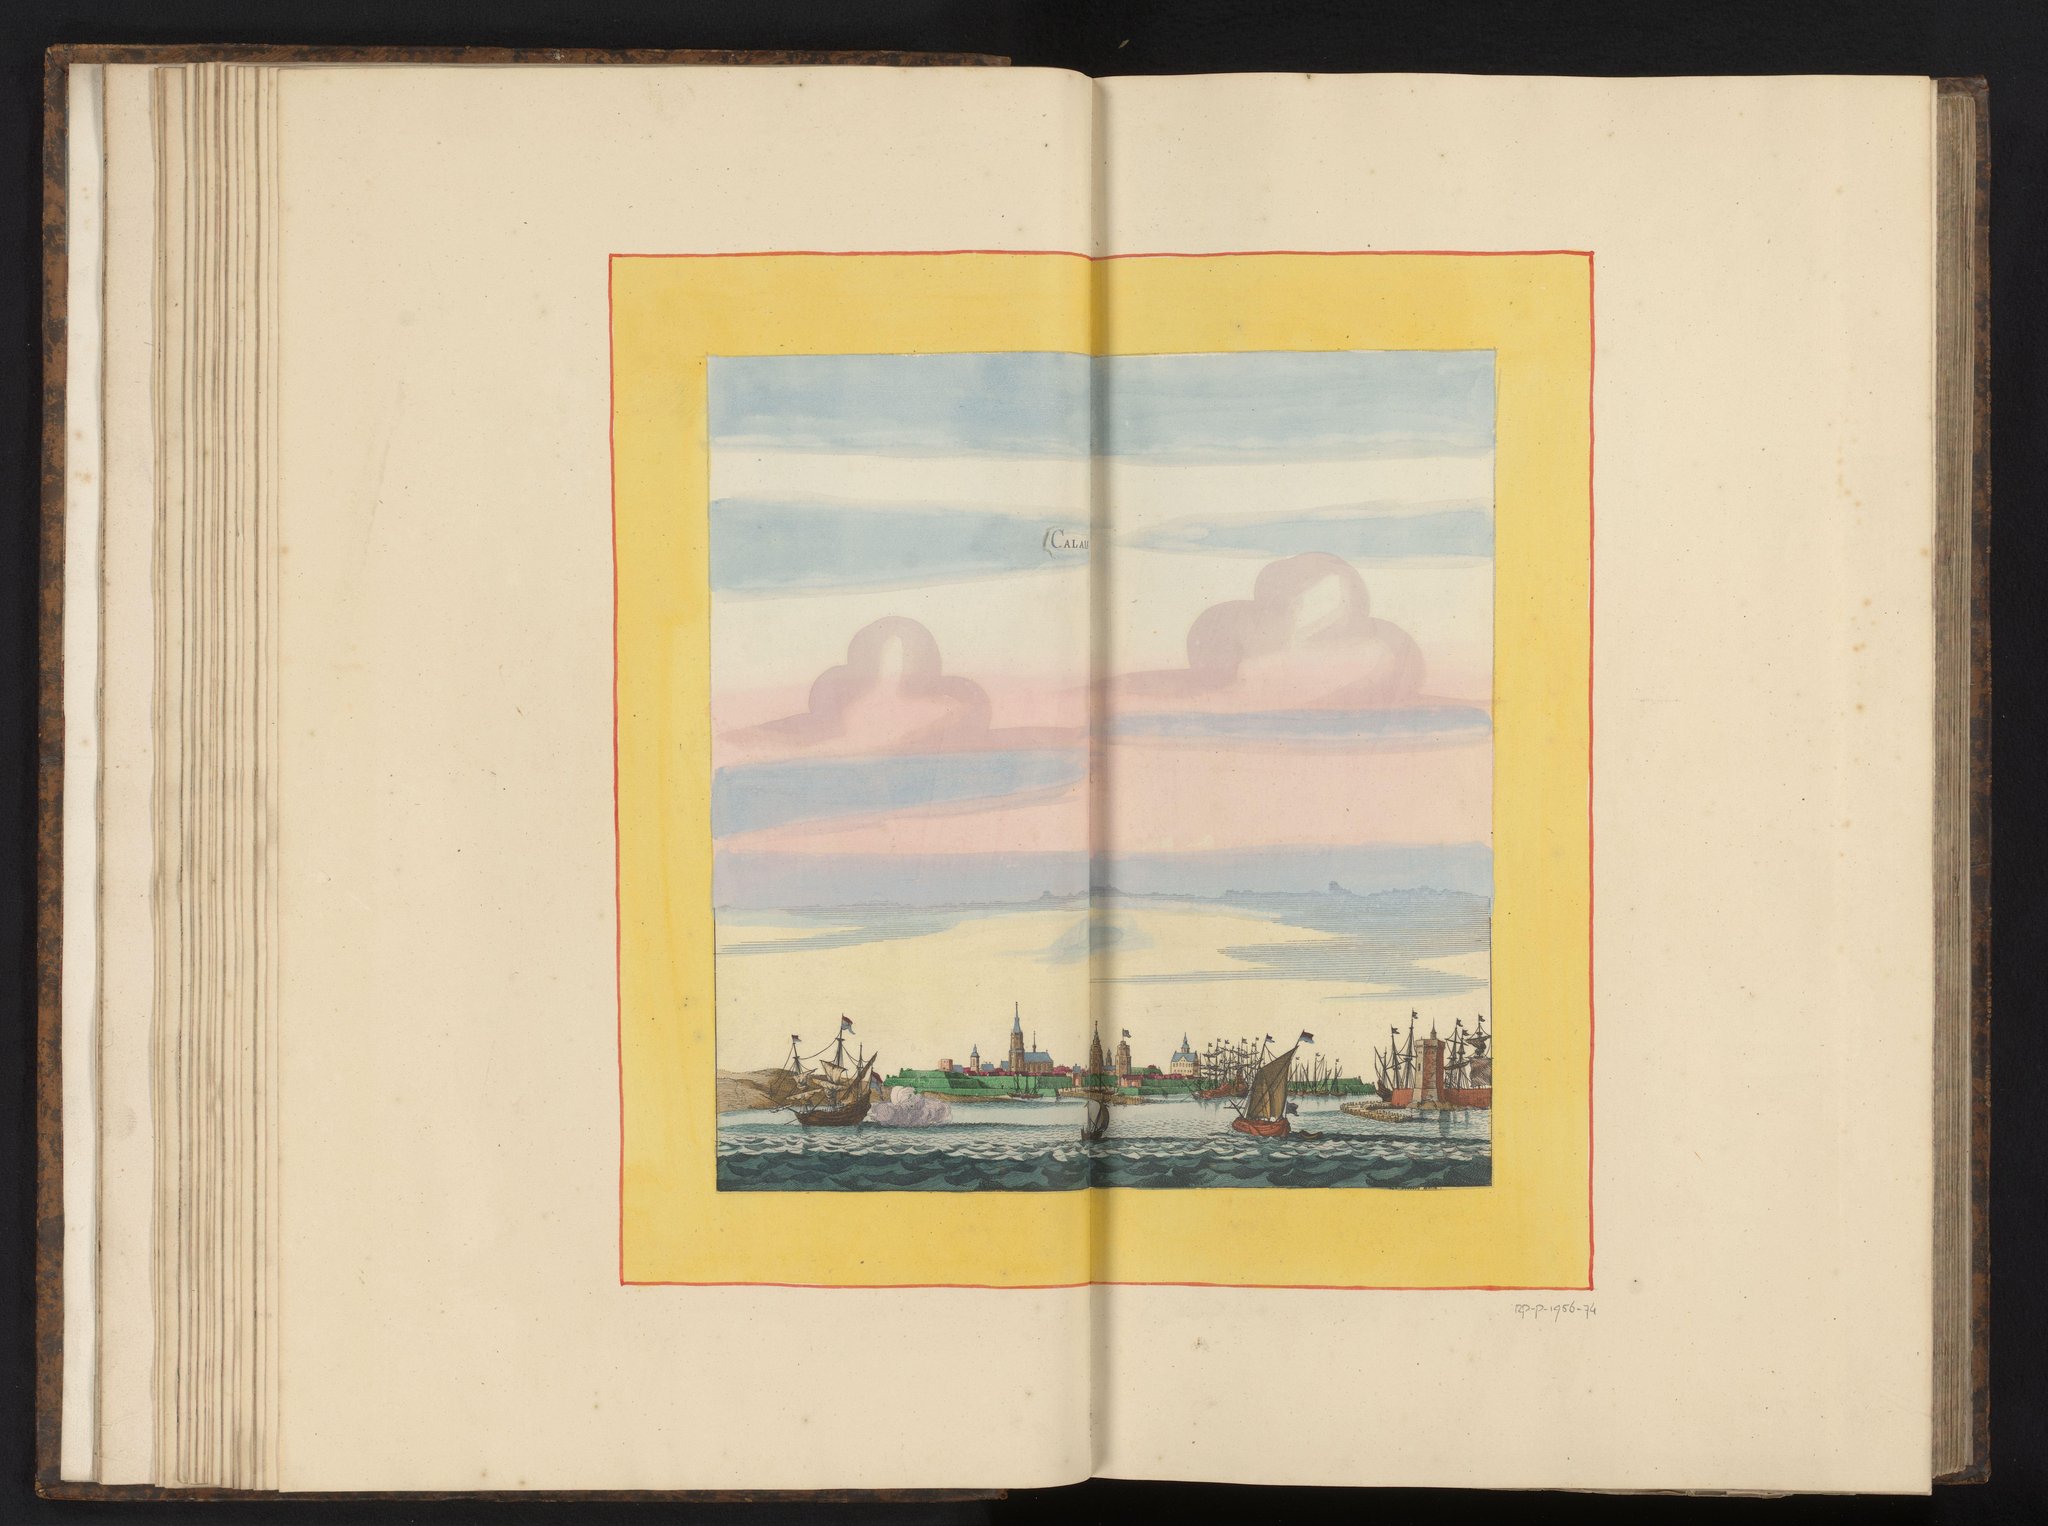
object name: album leaf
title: Gezicht op Calais vanaf het water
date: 1656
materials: paper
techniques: engraving, etching, hand coloring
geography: the hague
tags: city-view in general; 'veduta'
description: Prent uit: Zeiller, Martin. Topographia Galliae. 13 dln. Frankfurt: Caspar Merian, 1656, dl. 2, na p. 20. De titel is uit de originele prent gesneden. Boven de gravure is een deel lucht en wolken (bij)geschilderd, waarin de titel gelijmd is. Origineel op één plaat gedrukt met een soortgelijk gezicht op 'La Capelle' (RP-P-1956-77).